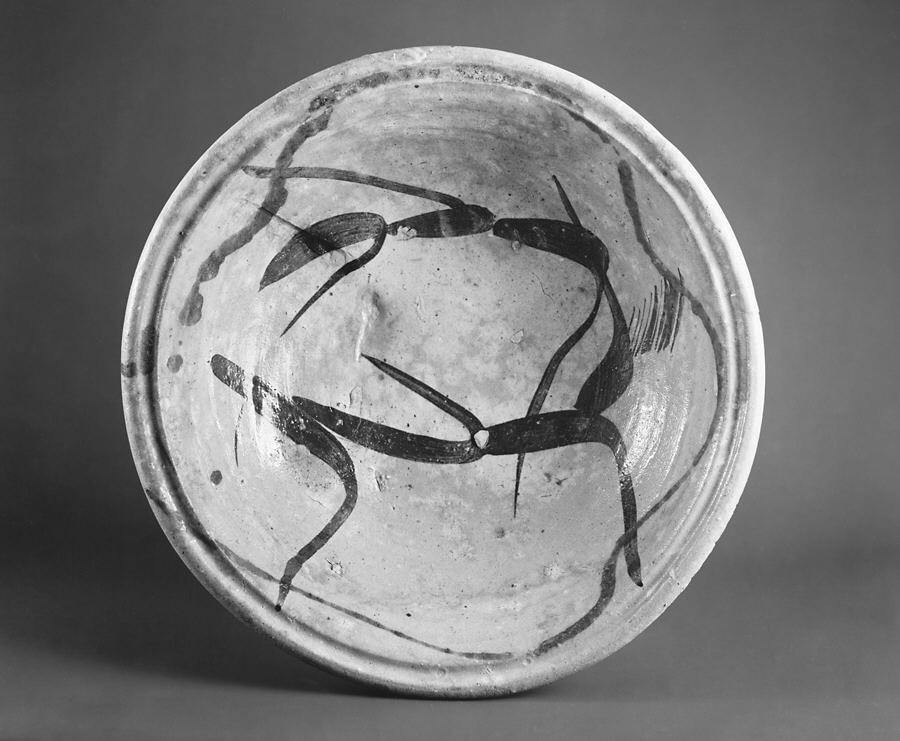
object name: bowl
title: Bowl with Reed Design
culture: japanese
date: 1667-1700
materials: stoneware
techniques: glazing